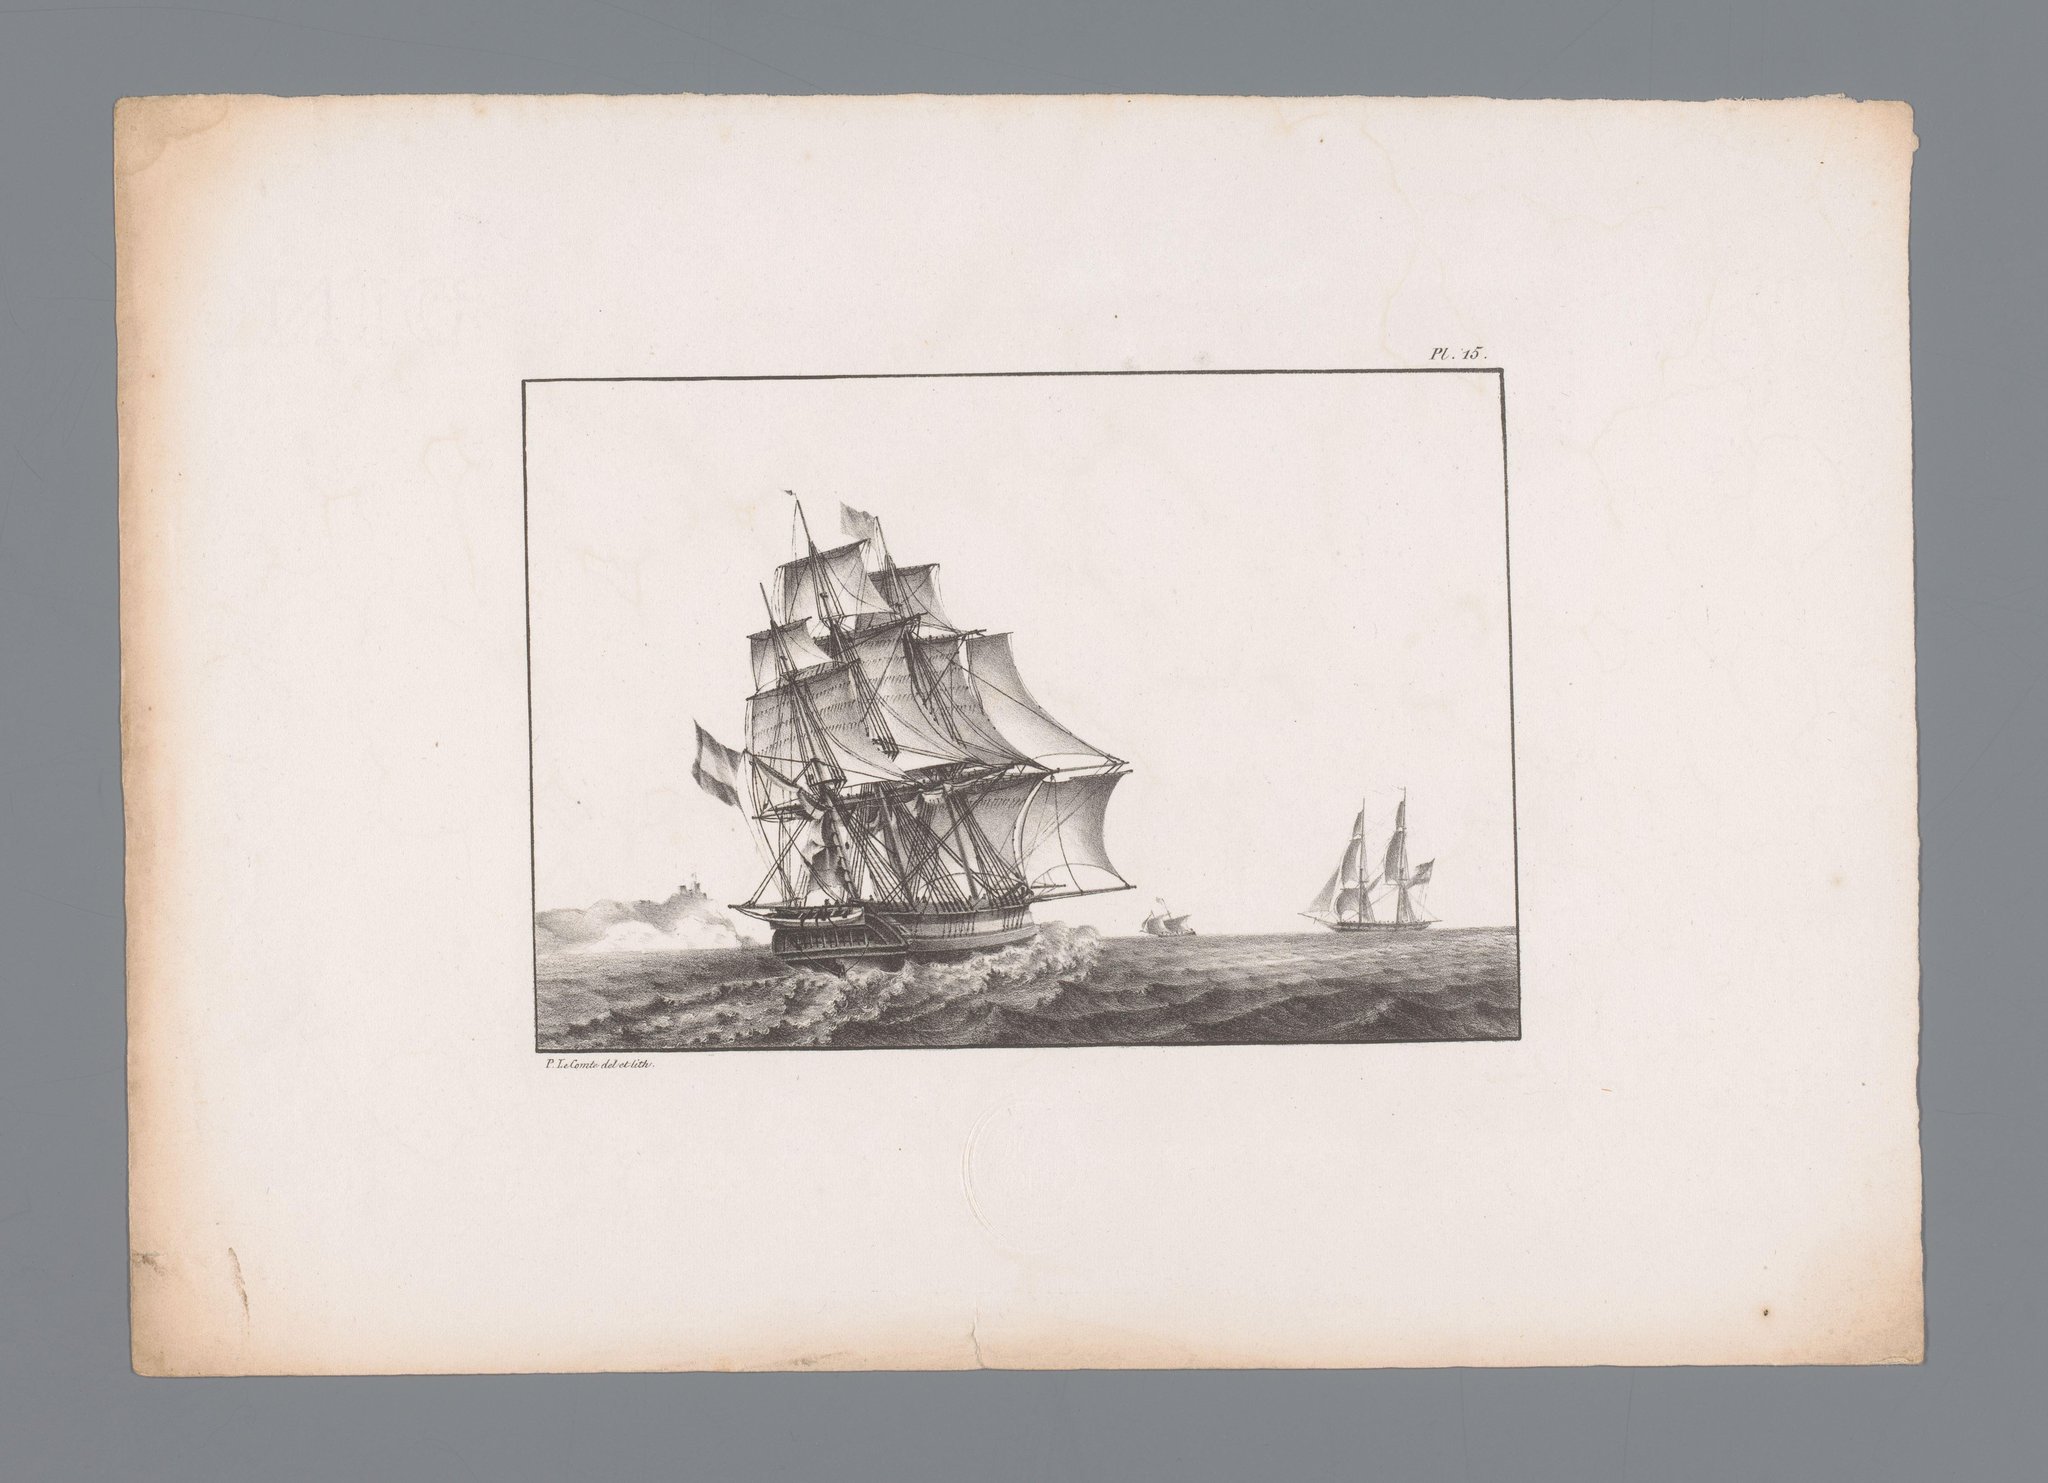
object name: print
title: Afbeeldingen van schepen en vaartuigen, in verschillende bewegingen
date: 1831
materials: paper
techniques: lithograph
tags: sailing-ship, sailing-boat, ships (in general), merchant shipping, shipping trade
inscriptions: collector's mark: ‘PLC RMWO’, collector's mark: Lugt 2228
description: Genummerd rechtsboven: Pl. 15. Deze prent maakt deel uit van een omslag met negentien prenten.